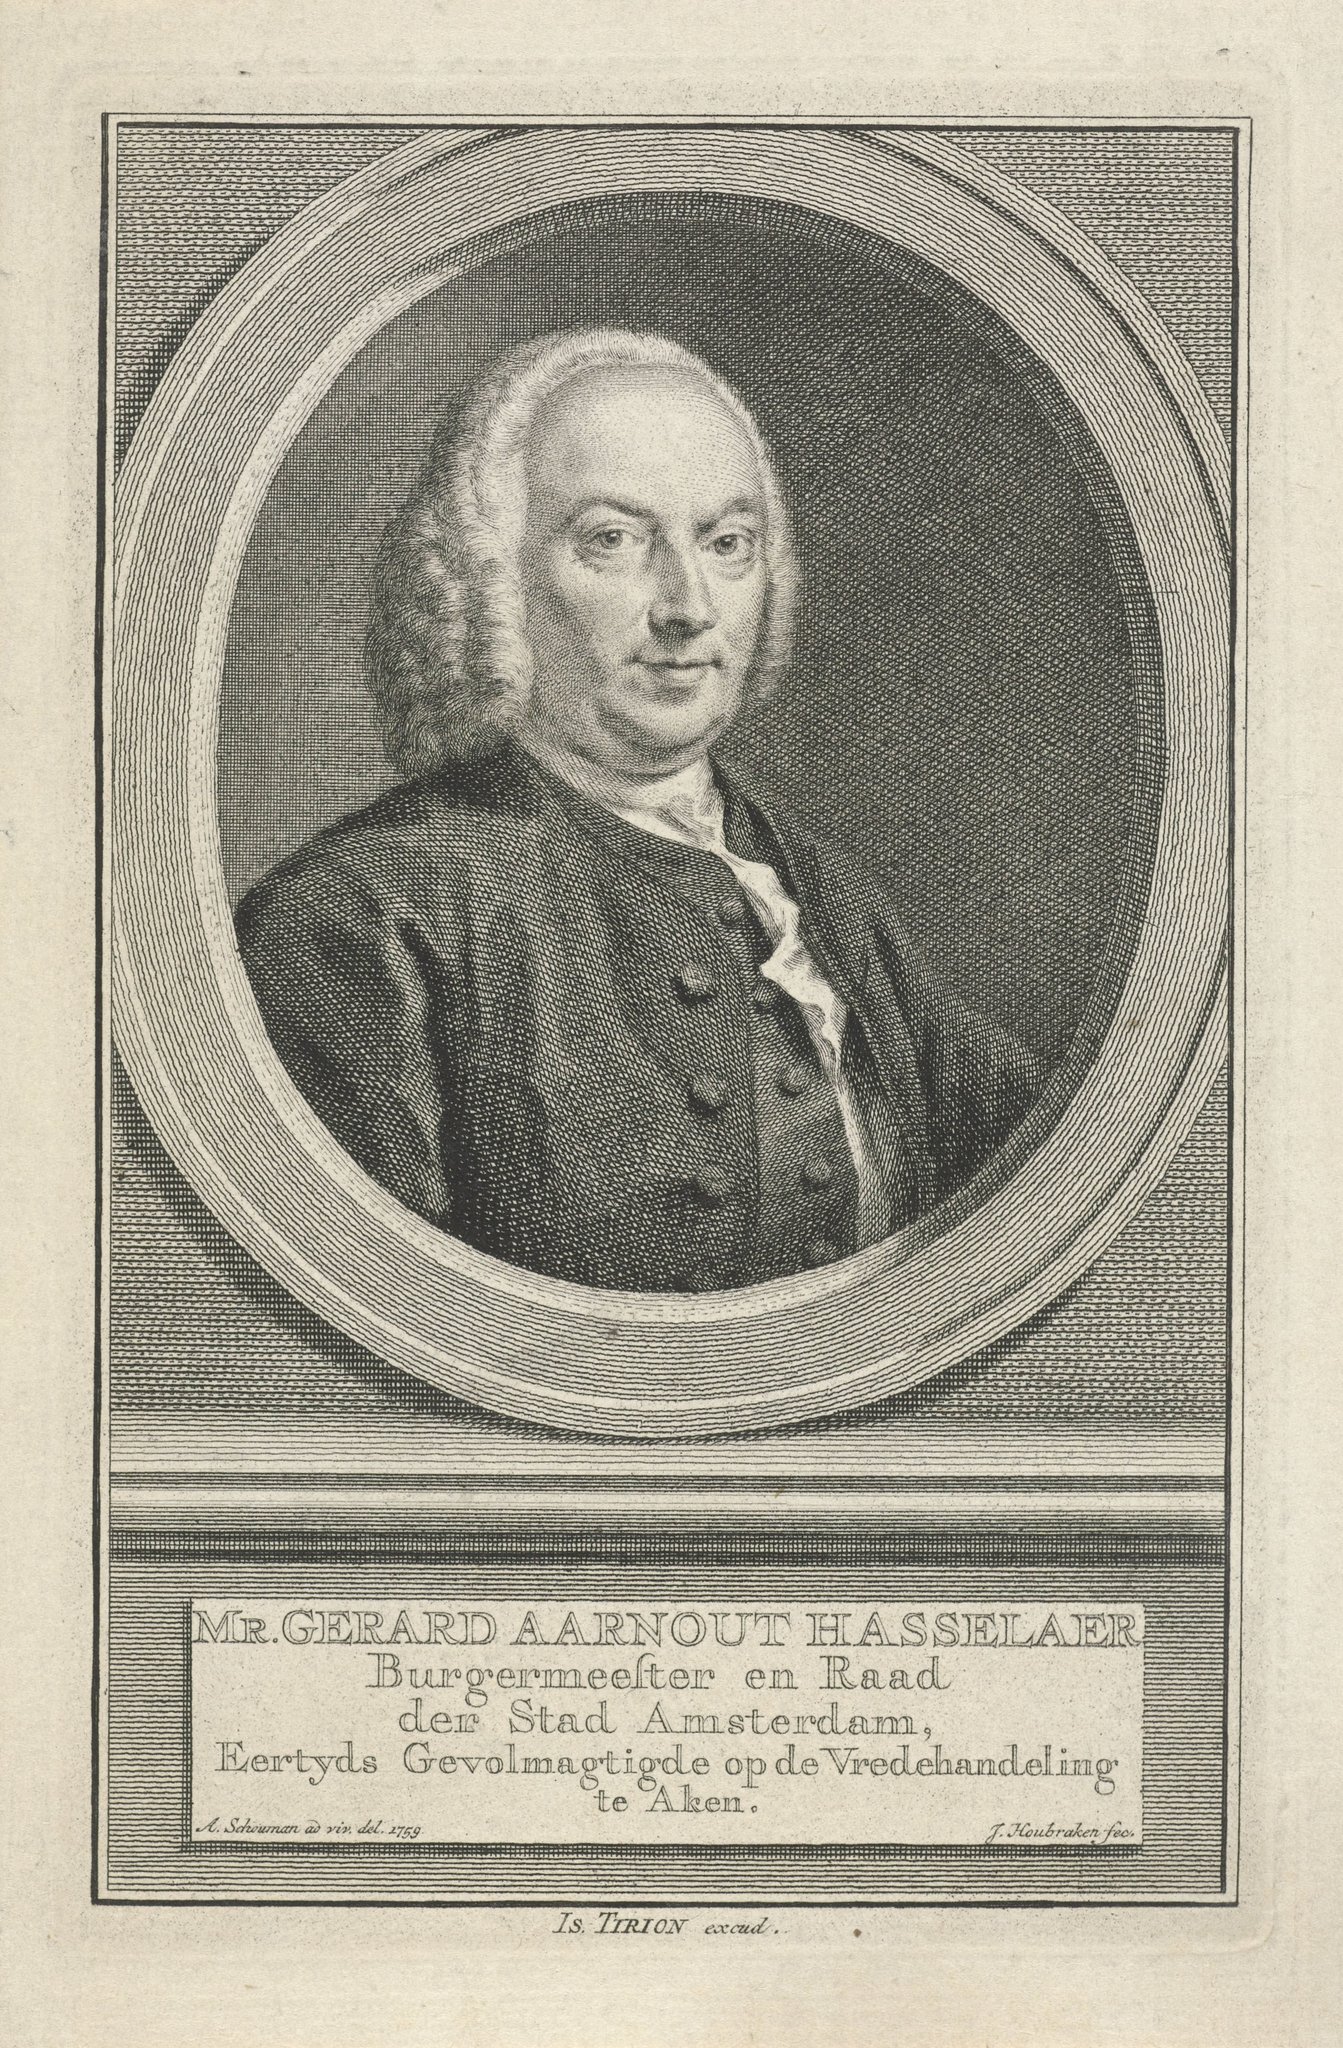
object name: print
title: Portret van Gerard Aarnout Hasselaer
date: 1759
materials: paper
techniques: engraving, etching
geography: amsterdam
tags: mayor, gerard aarnout hasselaer, mayor, burgomaster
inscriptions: collector's mark: Lugt 2228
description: Prent ook gebruikt in: Jan Wagenaar, Vaderlandsche historie, vervattende de geschiedenissen der nu Vereenigde Nederlanden, inzonderheid die van Holland (...), 21 delen. Amsterdam, Isaak Tirion, 1749-59.